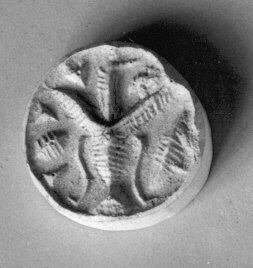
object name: stamp seal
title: Stamp seal with loop handle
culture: iranian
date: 1001-2000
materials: stone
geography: iran (?)